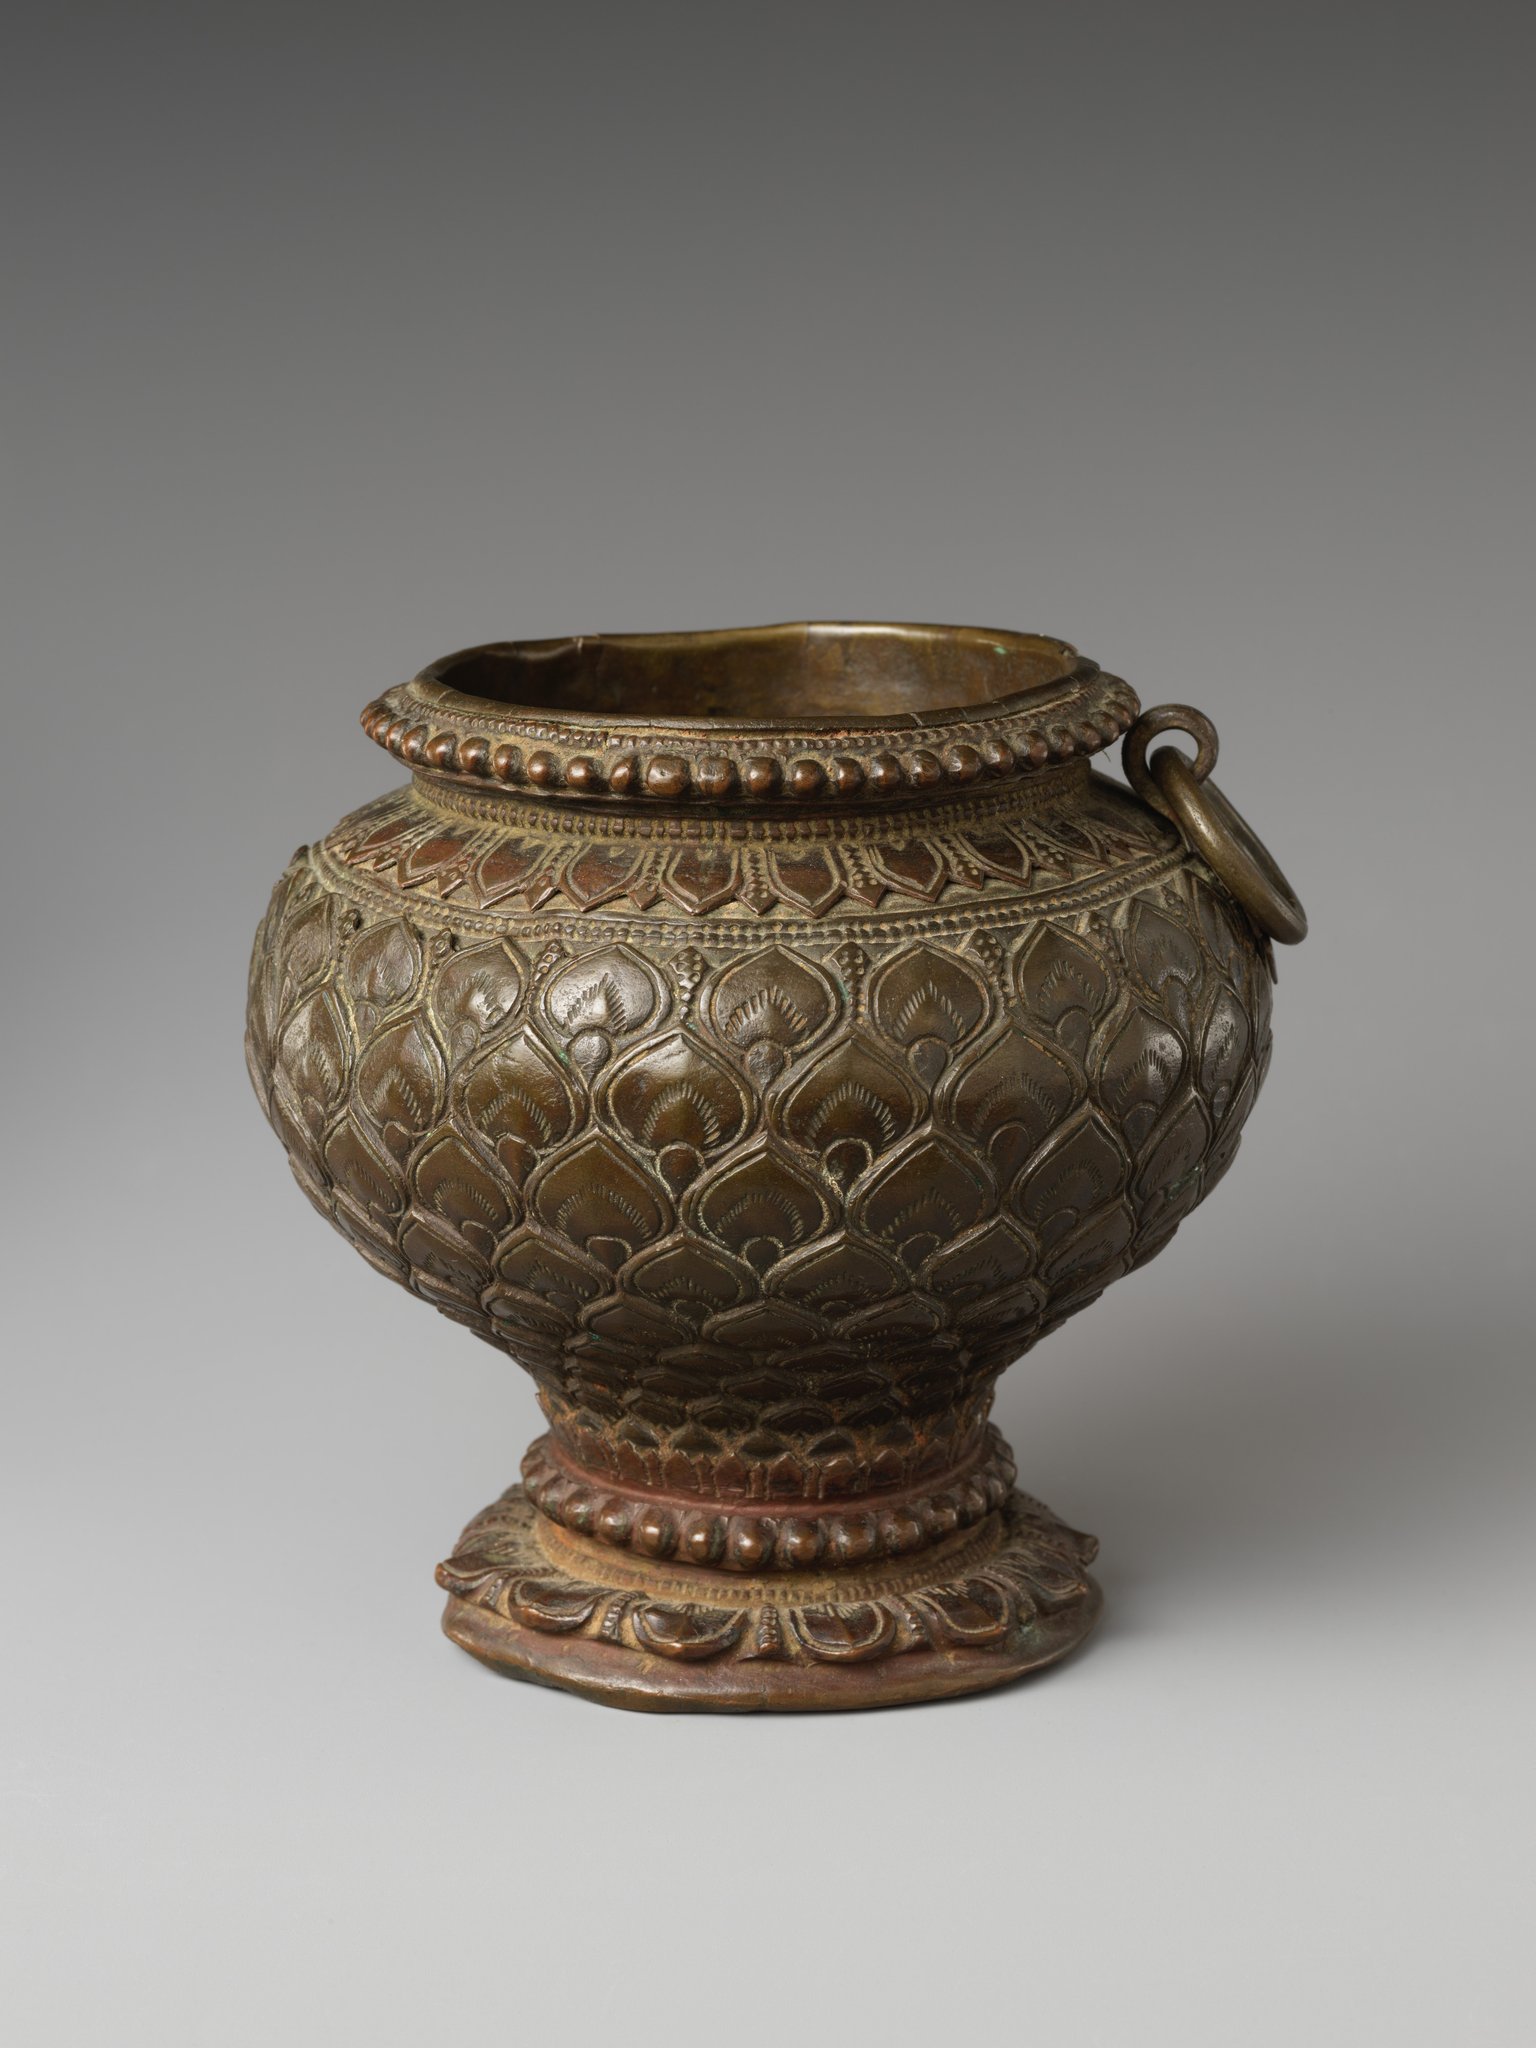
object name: vessel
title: Ritual Vessel of Lotus Form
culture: kashmiri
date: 901-1000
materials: copper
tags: kashmir